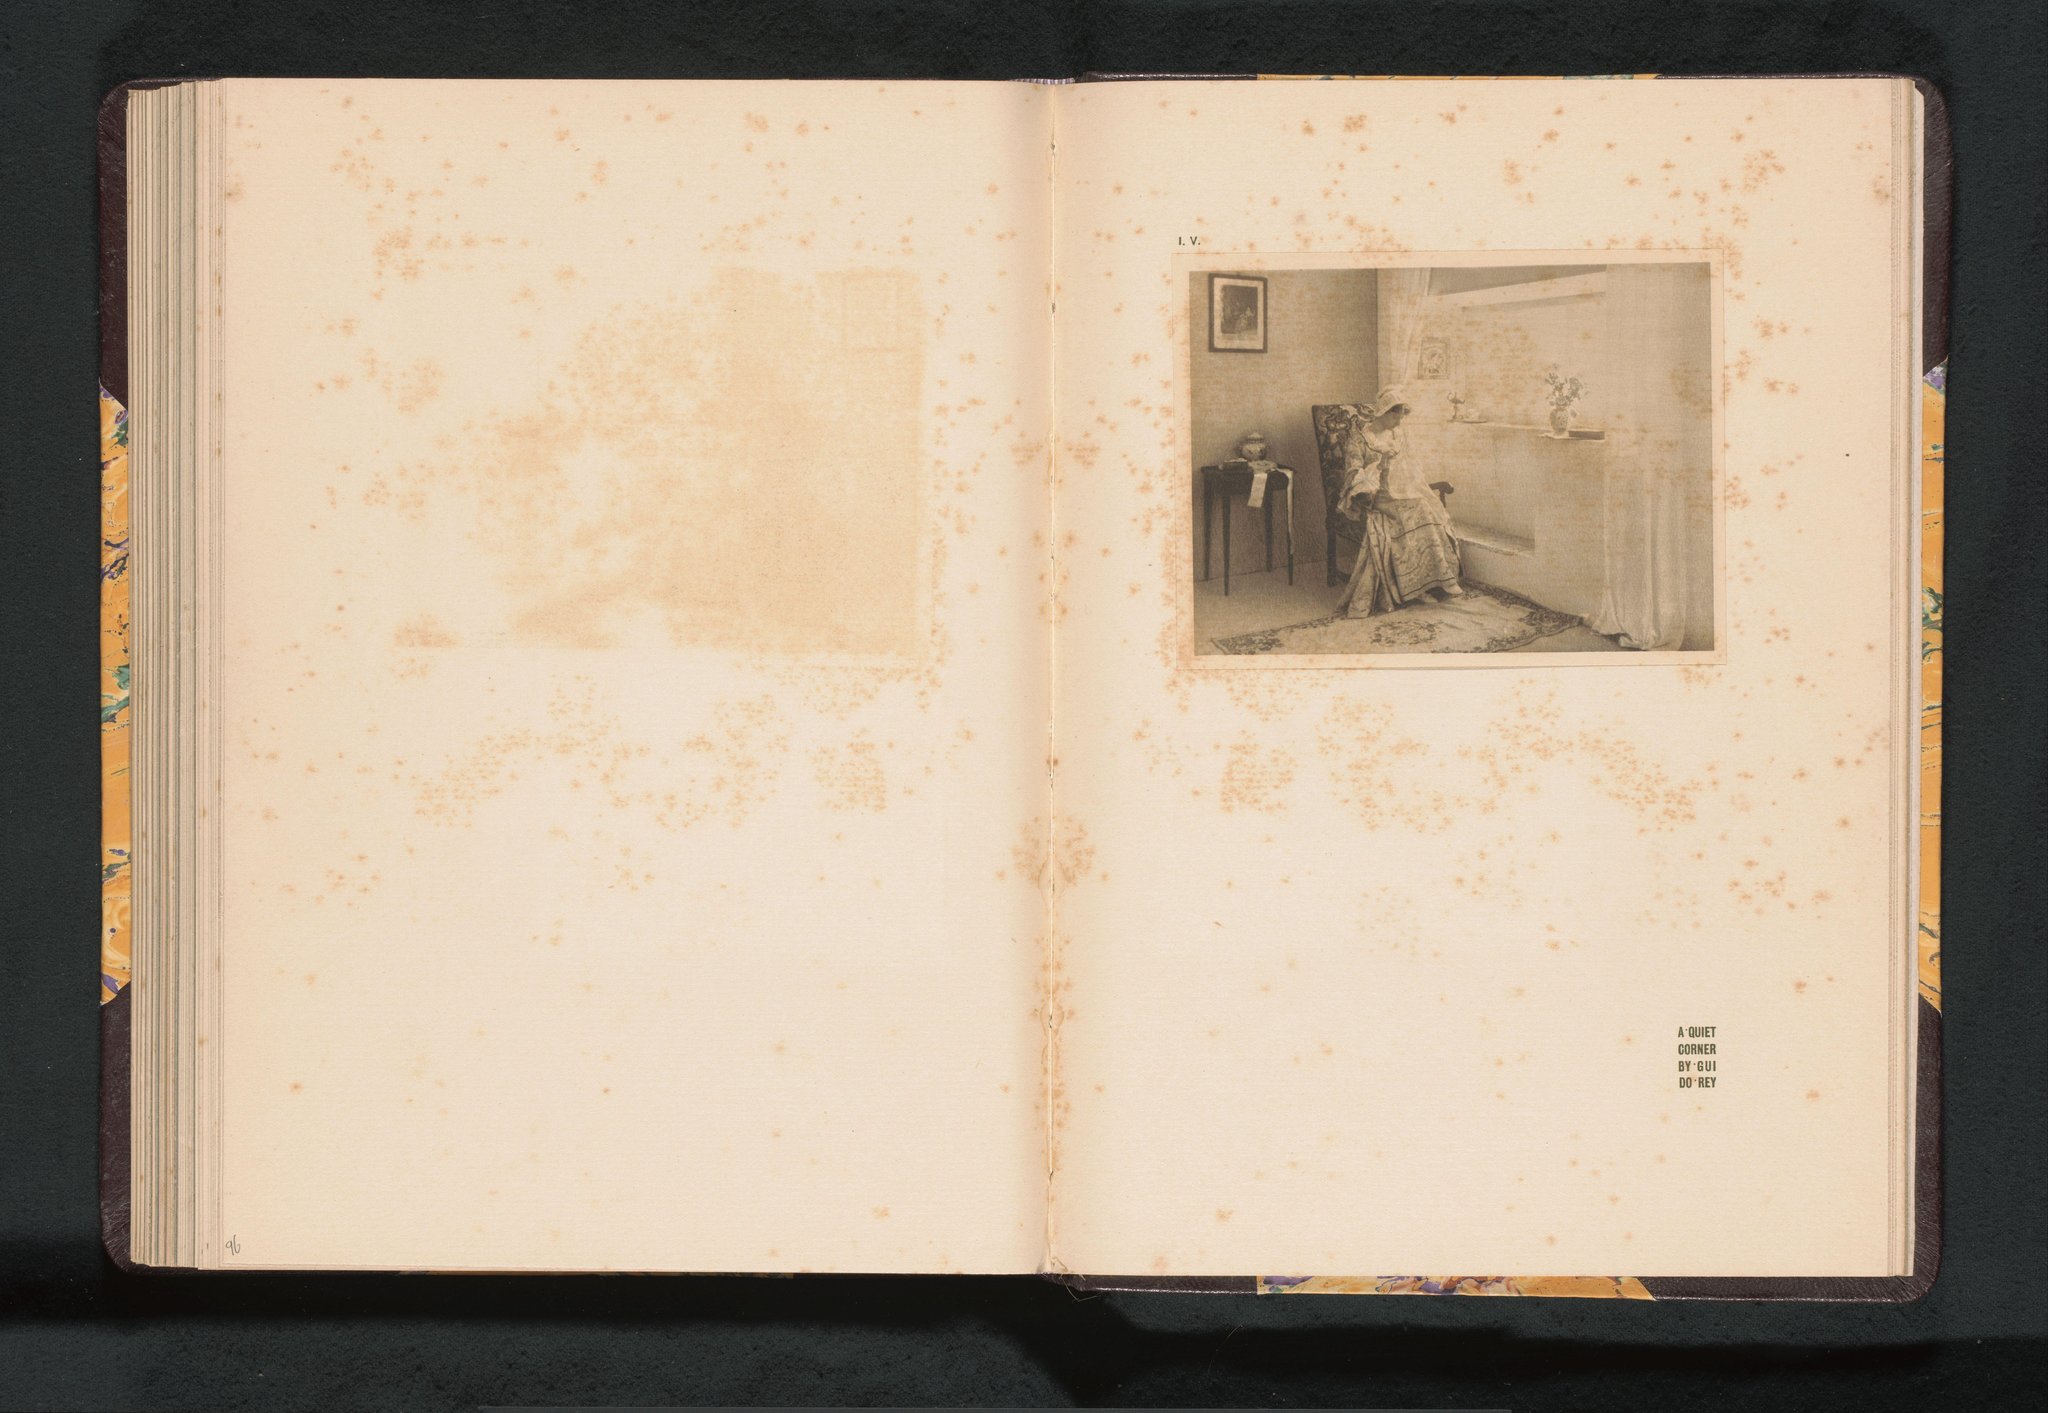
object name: page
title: Naaister bij het raam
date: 1900-1905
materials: paper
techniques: photoaquatint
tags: sewing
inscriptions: inscription: ‘A quiet corner by Guido Rey’, inscription: ‘I. V.’